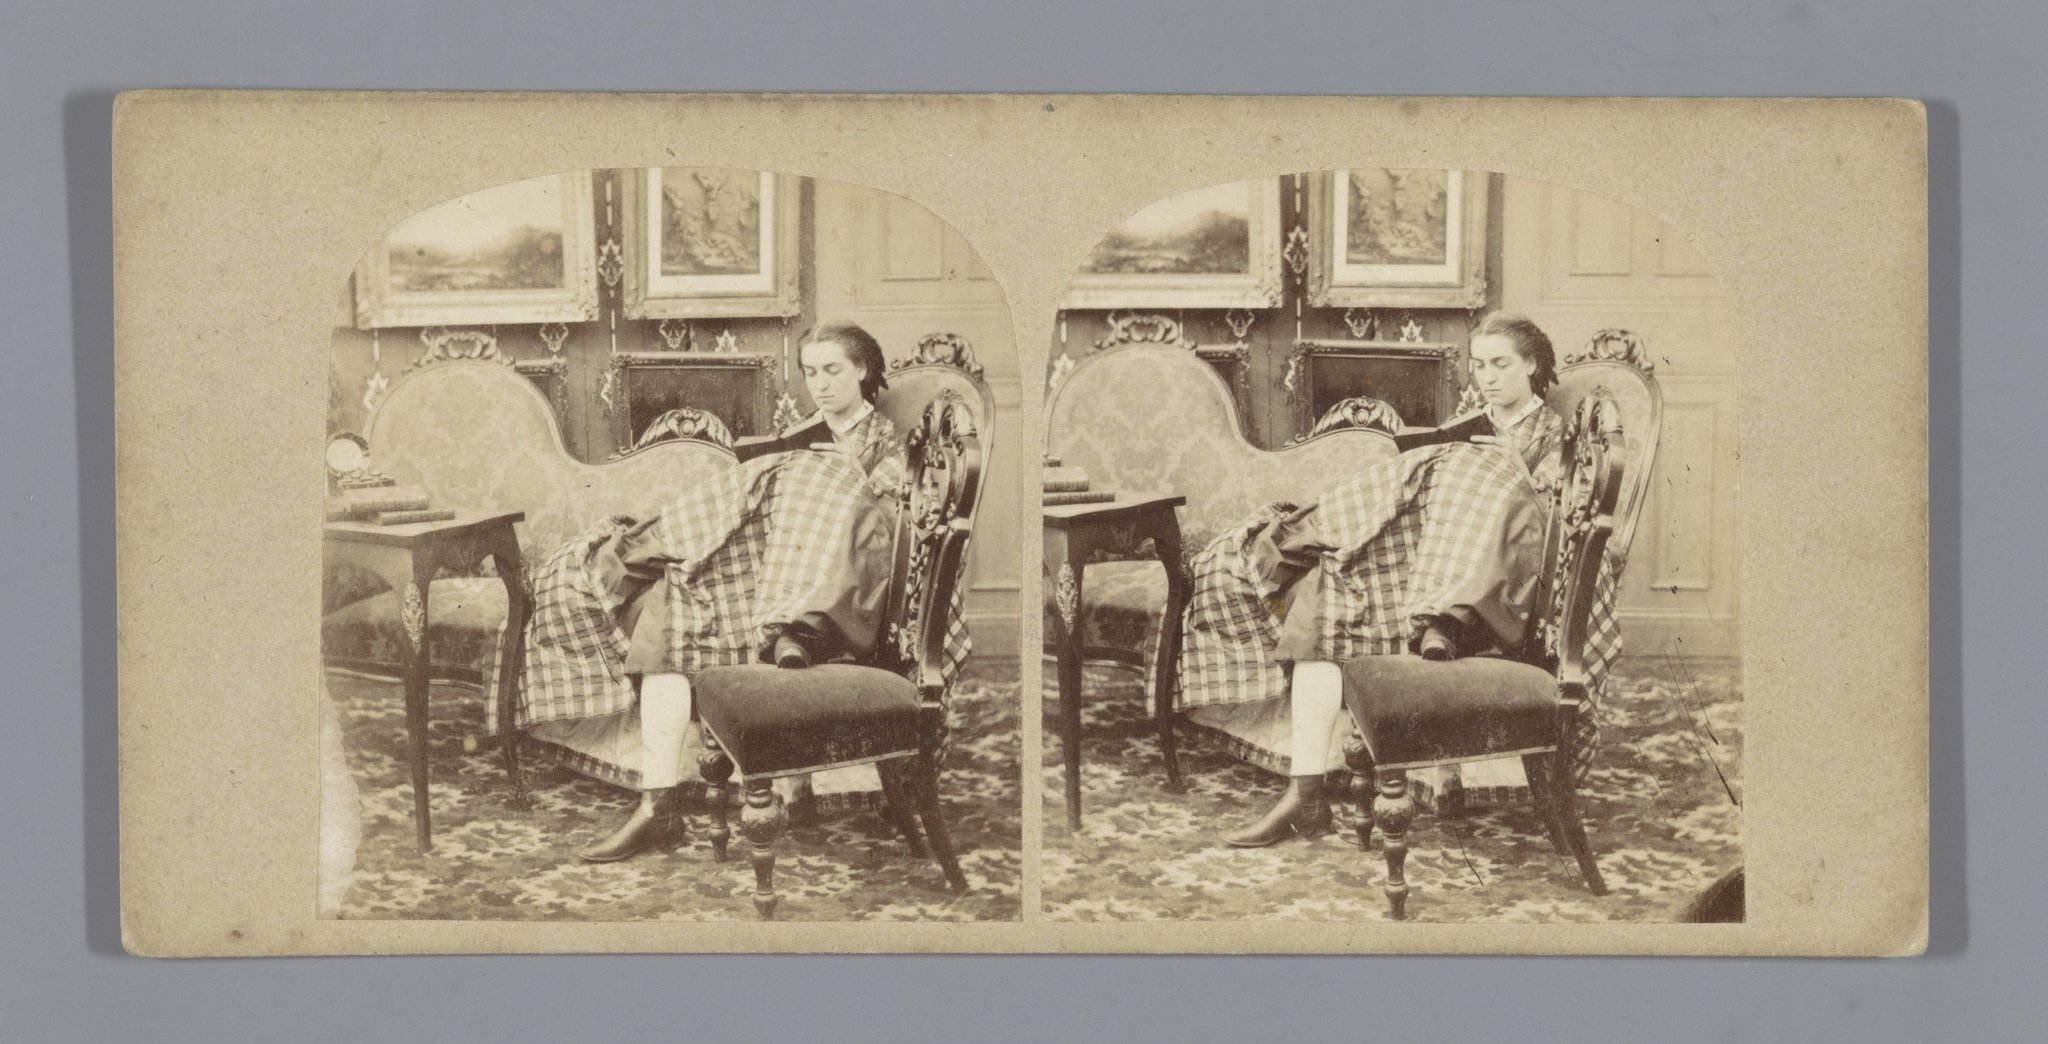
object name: stereograph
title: Lezende vrouw op een bank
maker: Anonymous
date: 1850-1880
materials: cardboard, photographic support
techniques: albumen print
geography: europe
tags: reading, europe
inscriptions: number: ‘60’, inscription: ‘vlg’